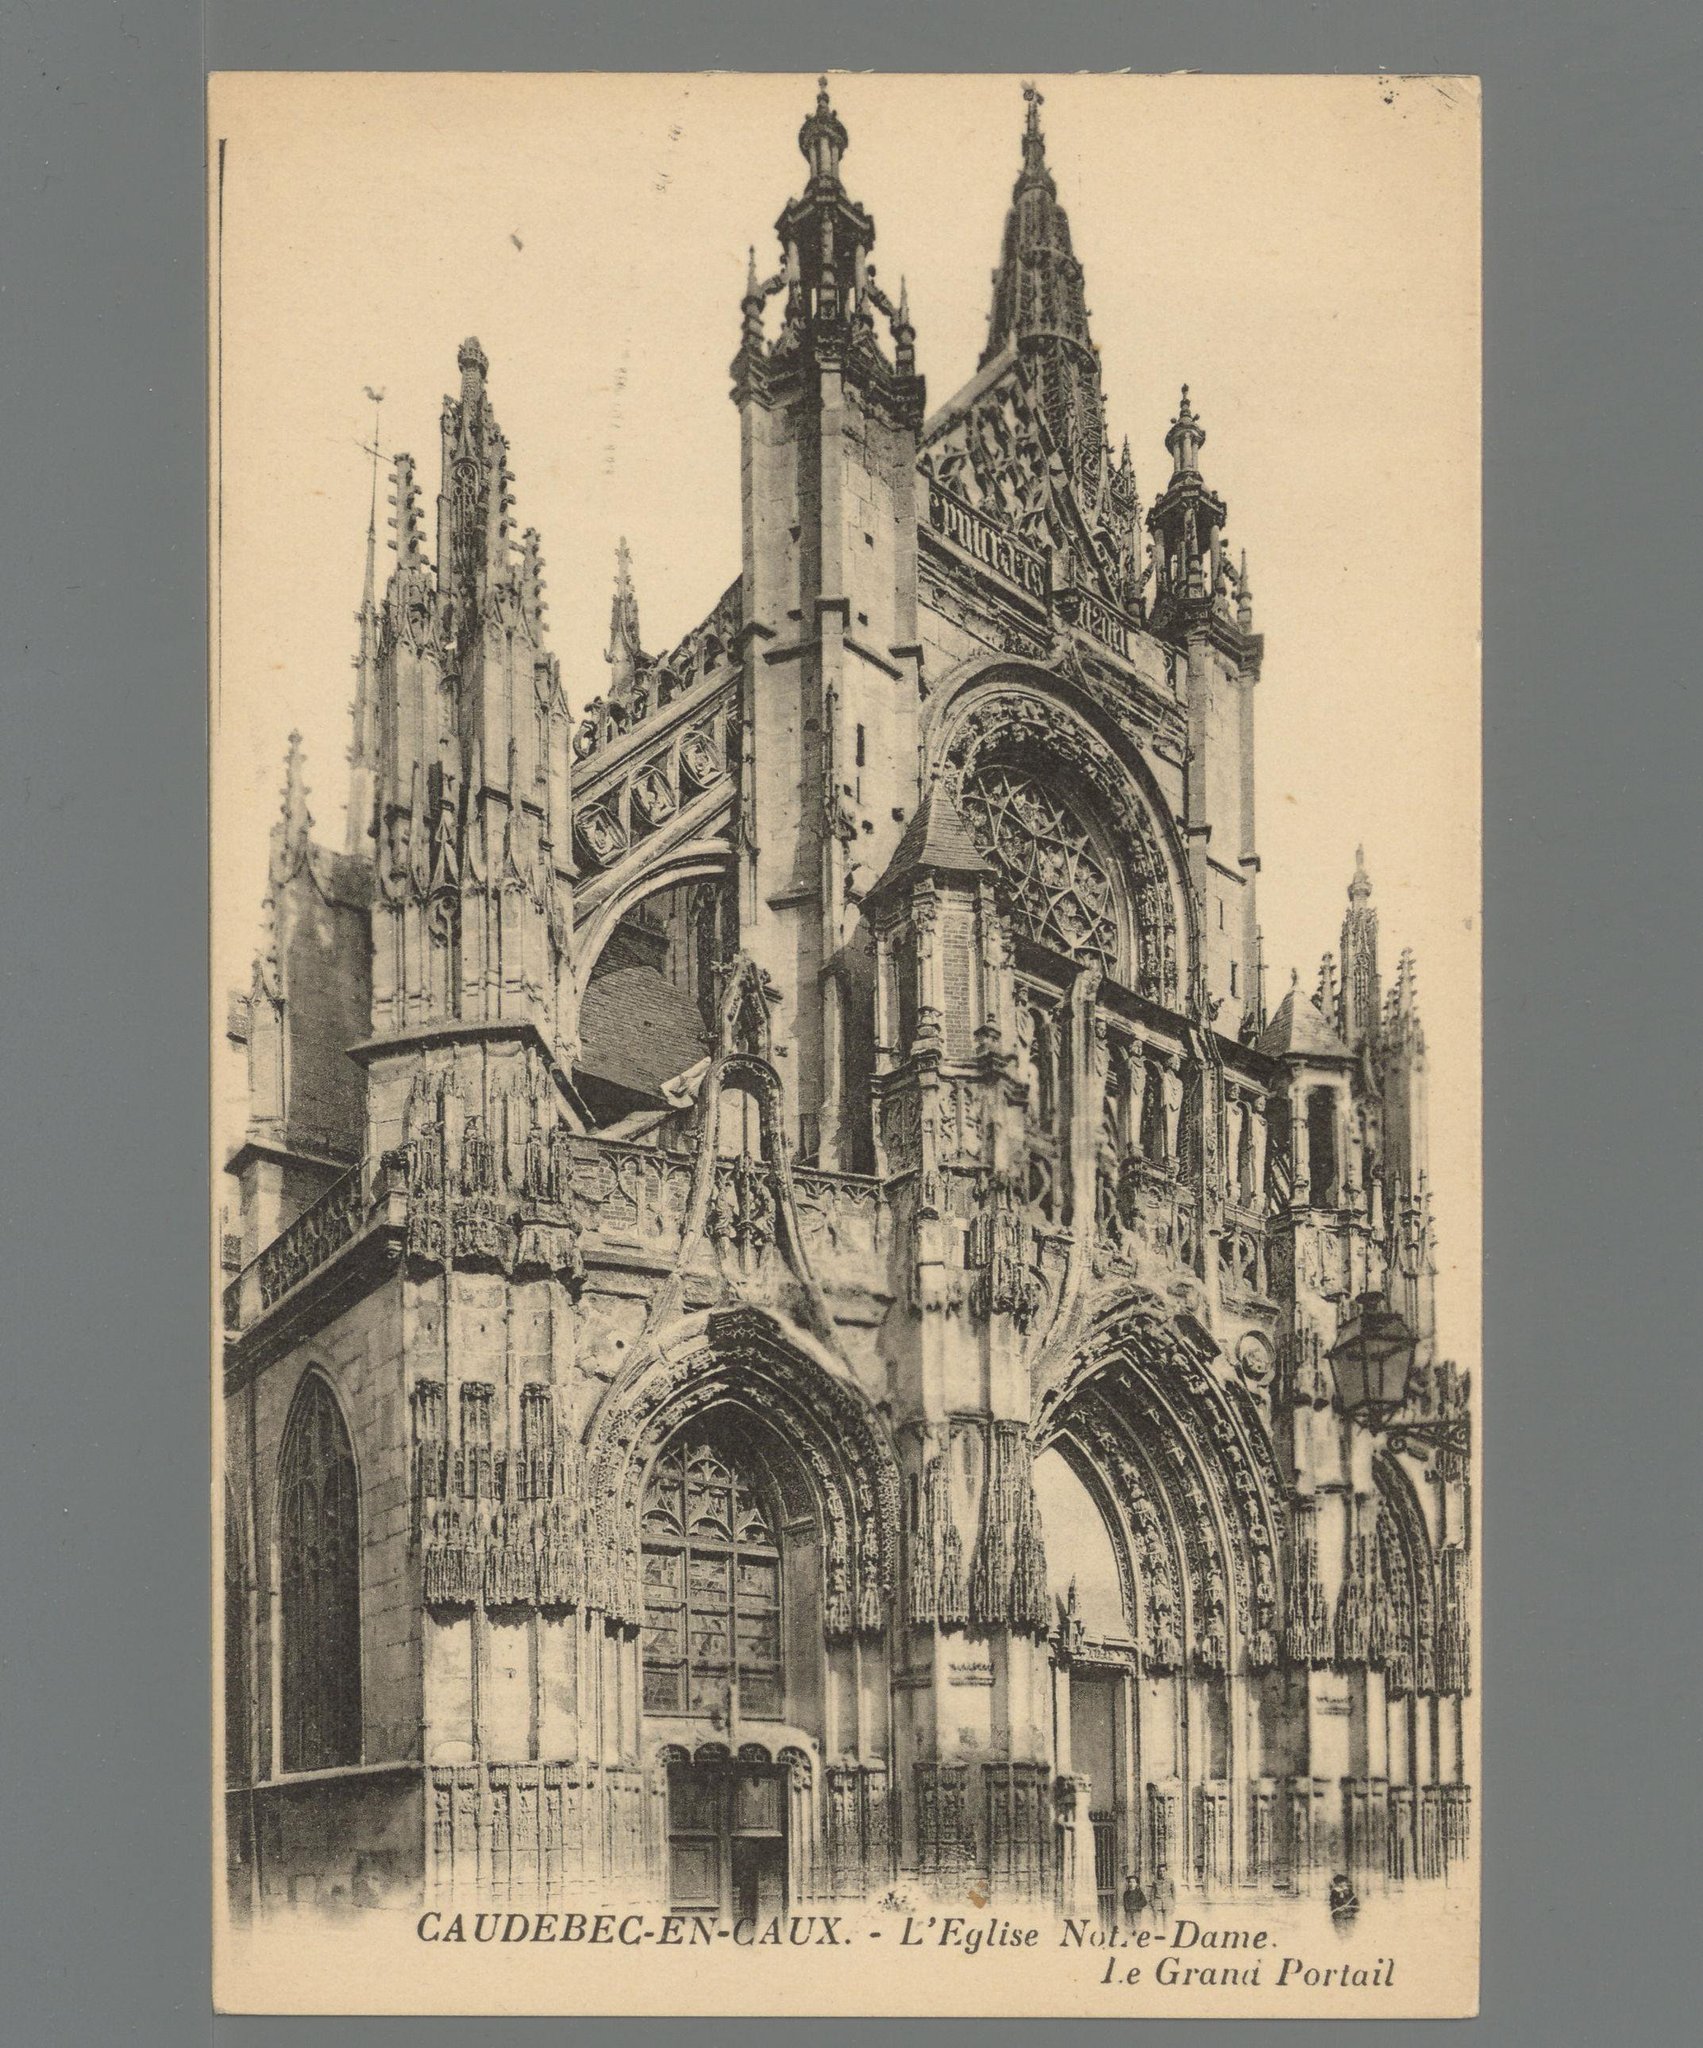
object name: photomechanical print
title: Caudebec-en Caux. L'Eglise Notre-Dame. Le Grand Portail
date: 1920-1932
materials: cardboard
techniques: photograph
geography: caudebec-en-caux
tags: parts of church exterior and annexes: portal